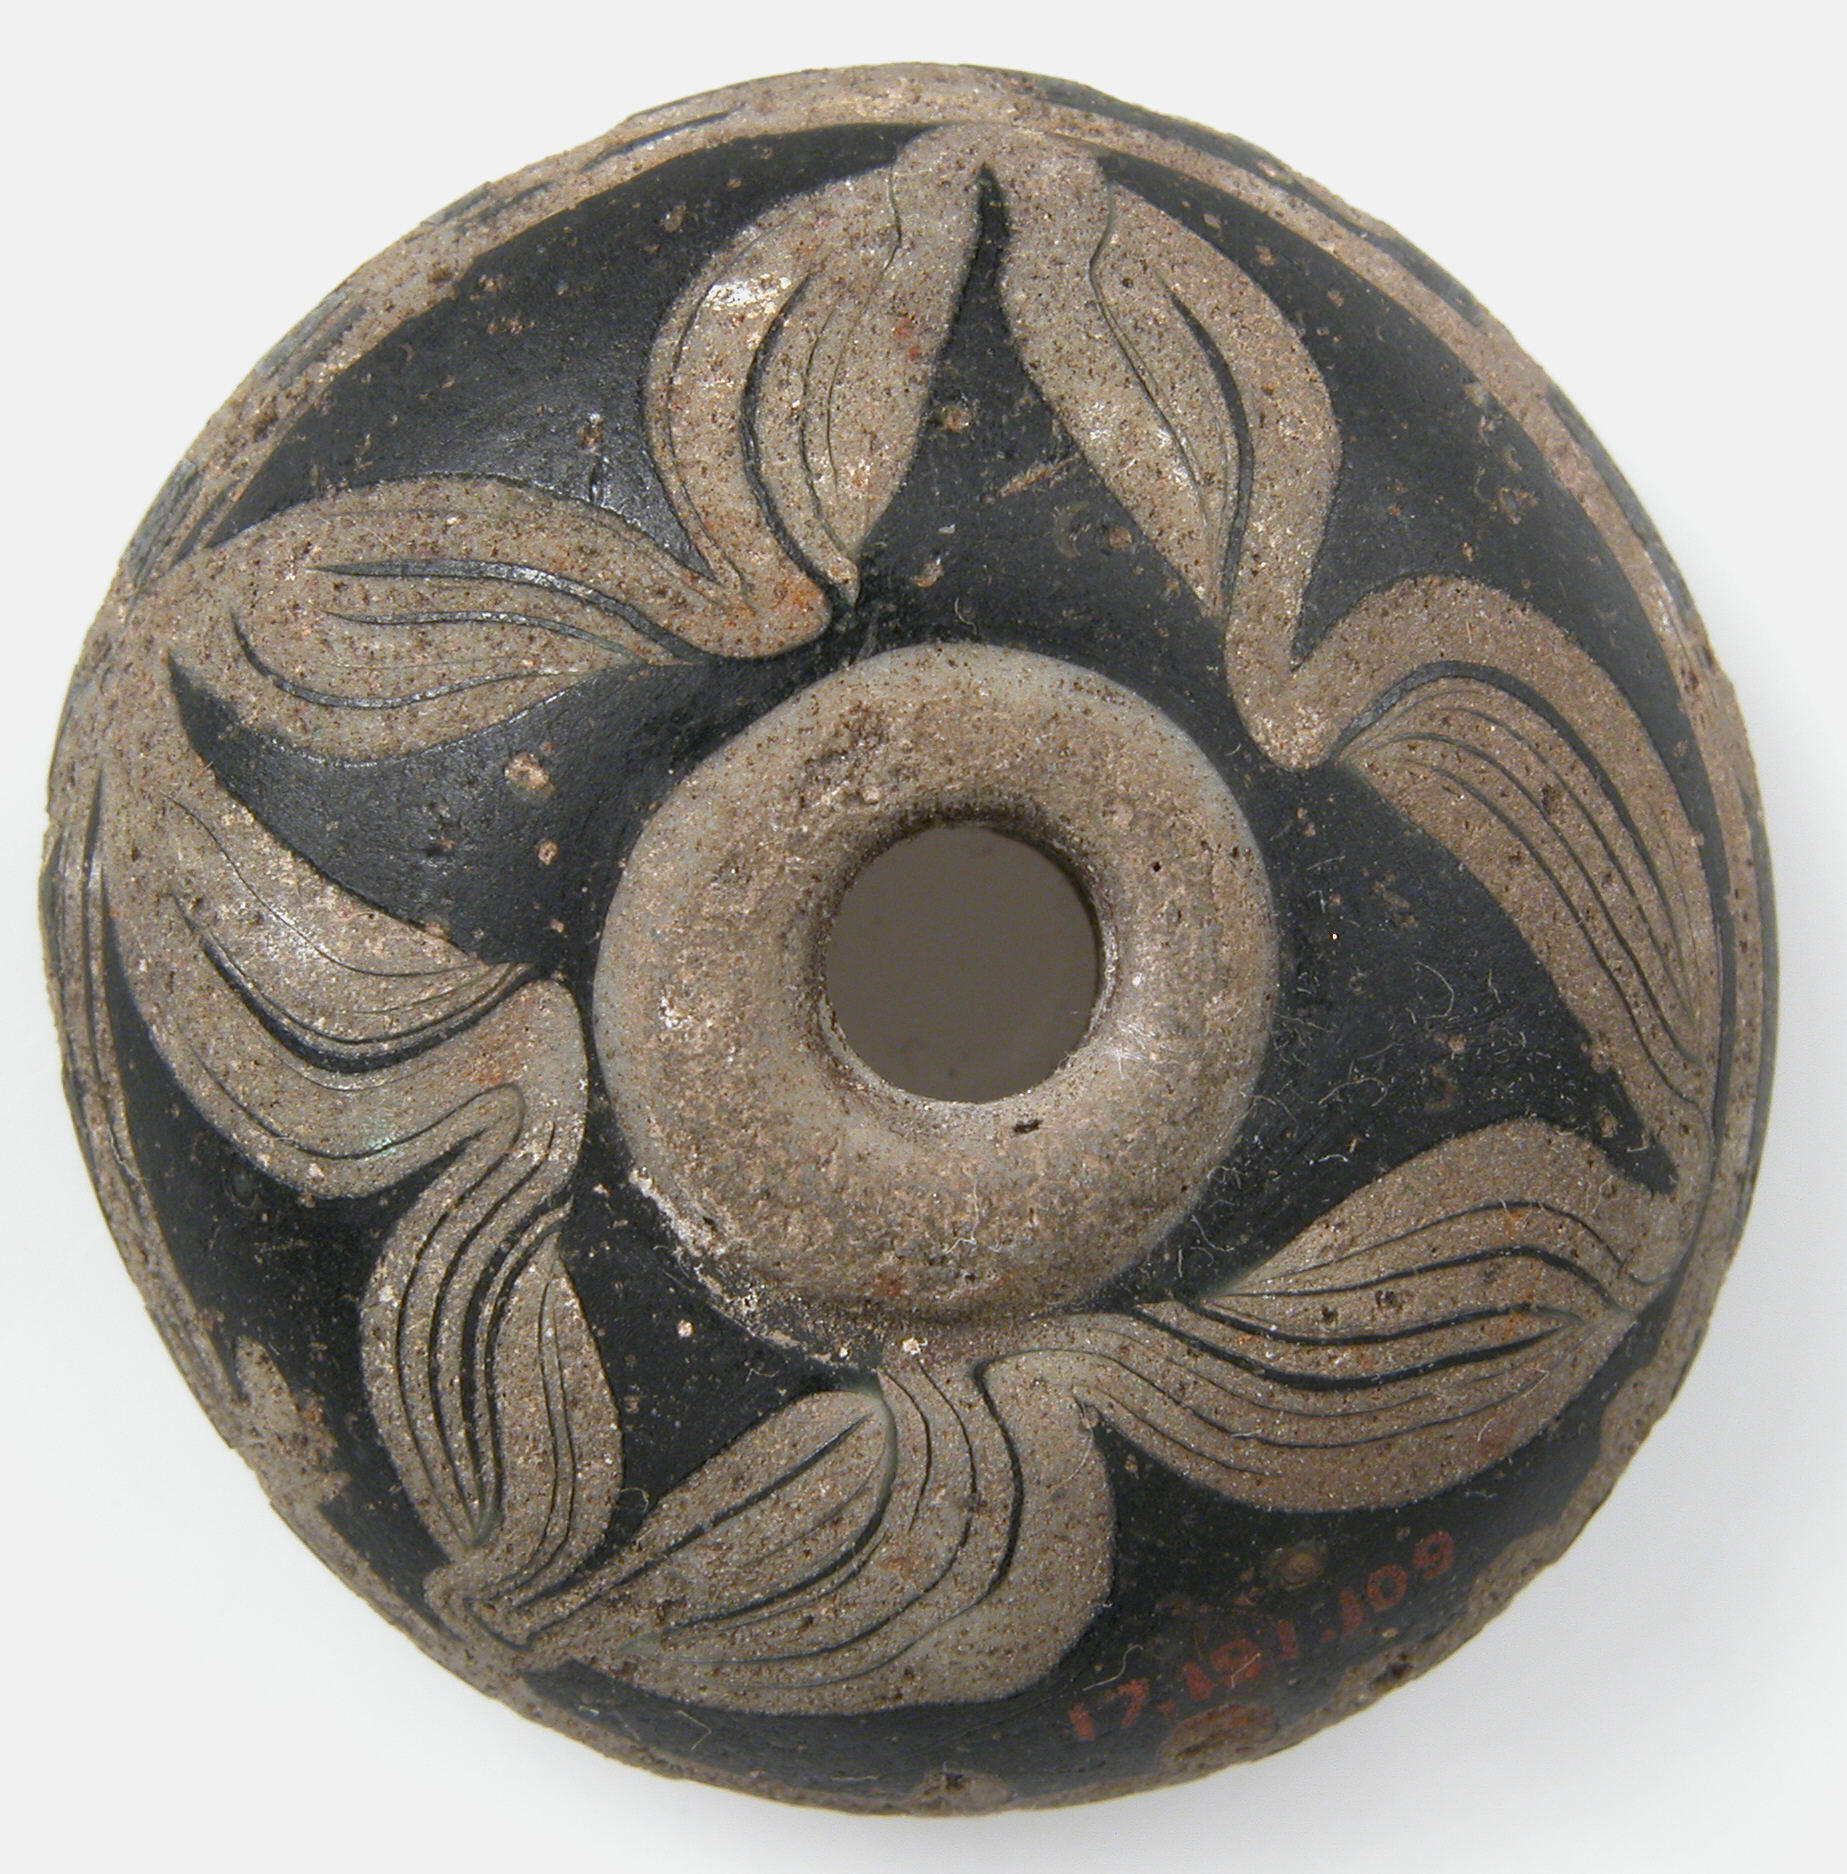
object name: bead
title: Flattened Hemispherical Bead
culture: frankish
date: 500-600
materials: earthenware, glaze